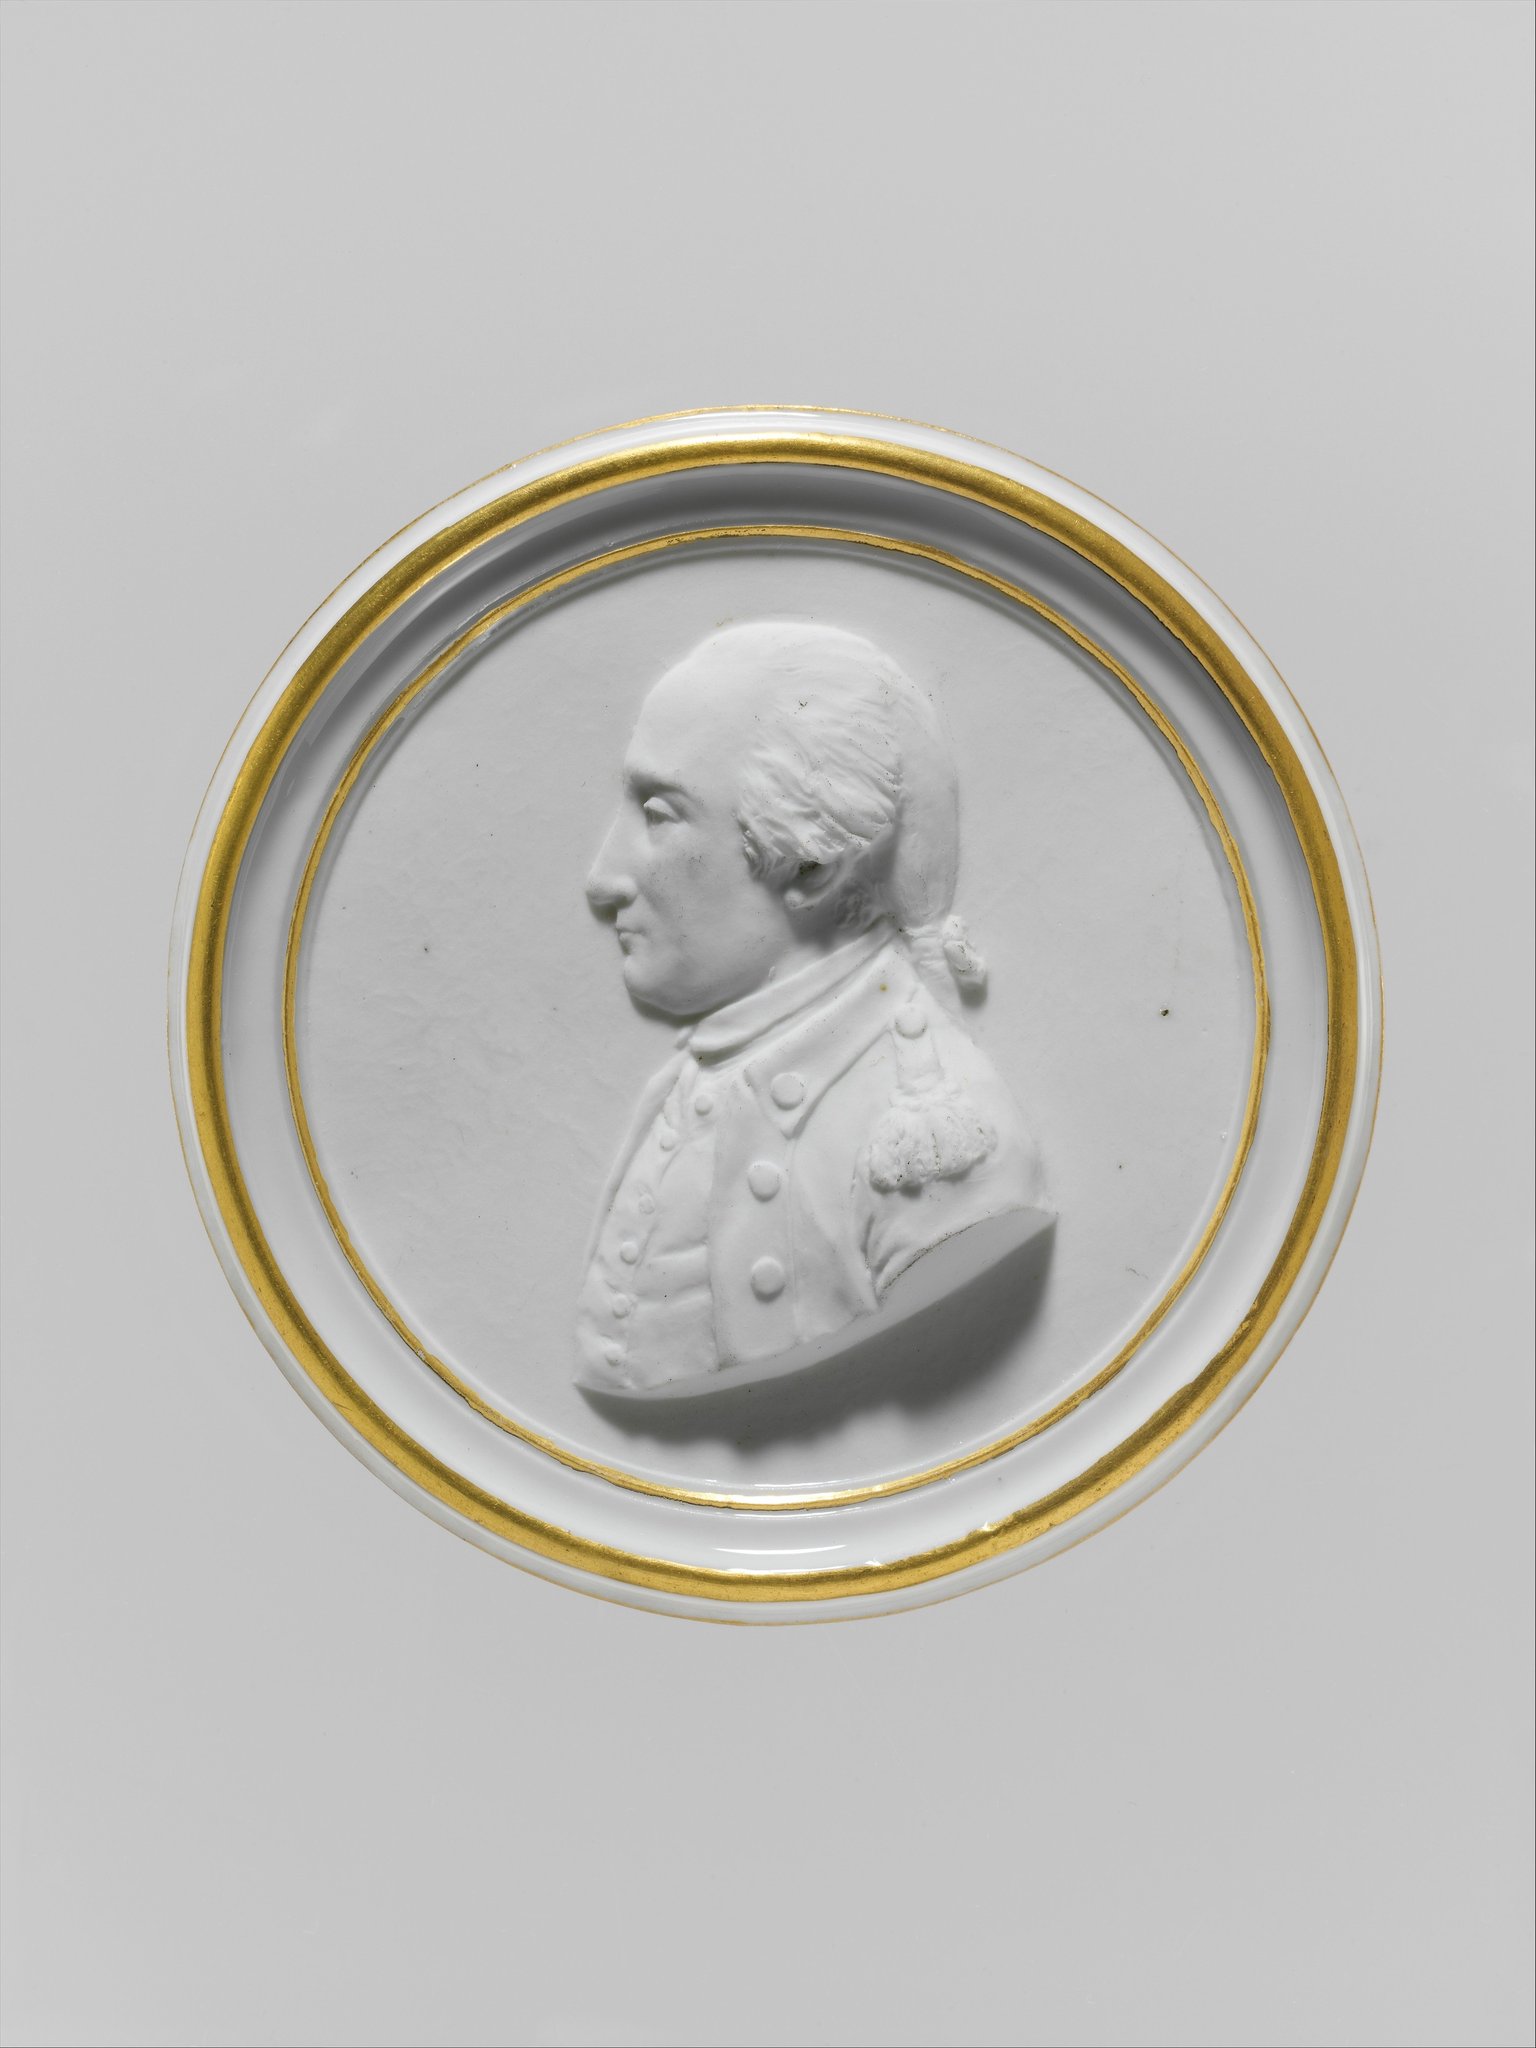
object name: medallion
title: George Washington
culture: french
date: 1776-1800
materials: porcelain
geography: france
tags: george washington,profiles